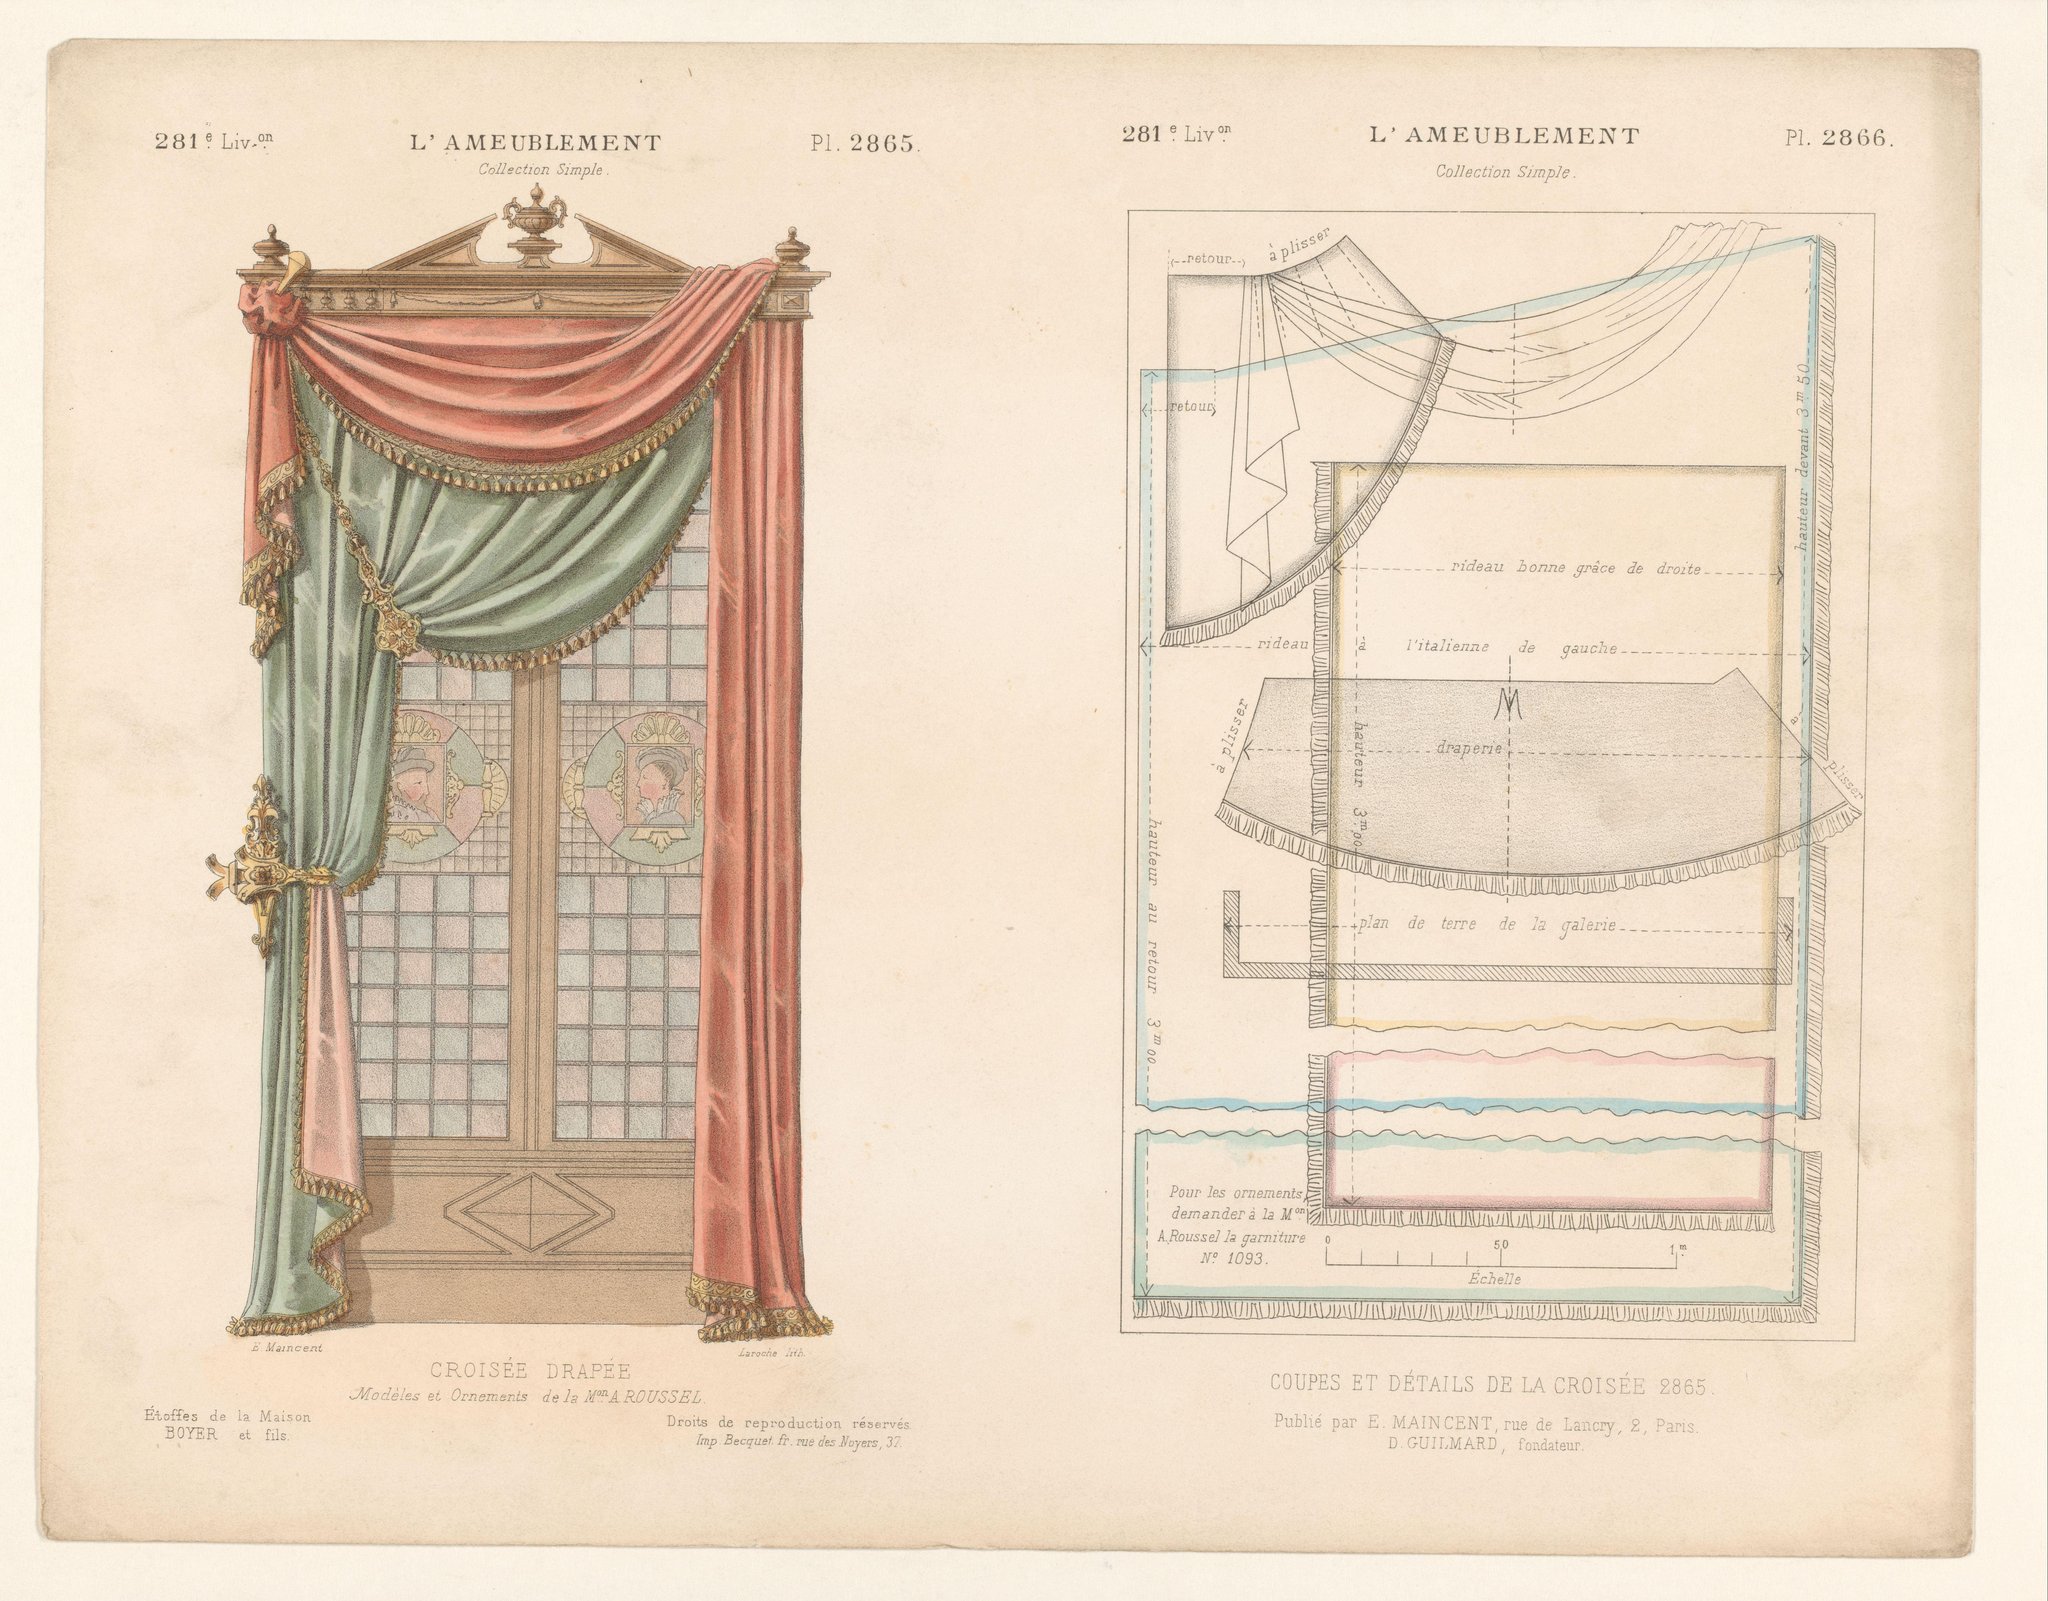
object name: print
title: Venster met gordijnen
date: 1885-1895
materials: paper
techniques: hand coloring, lithograph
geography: paris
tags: window, hangings and drapery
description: Een venster met gedrapeerde gordijnen. Rechts details van de draperieën. Prent uit 281e Livraison.